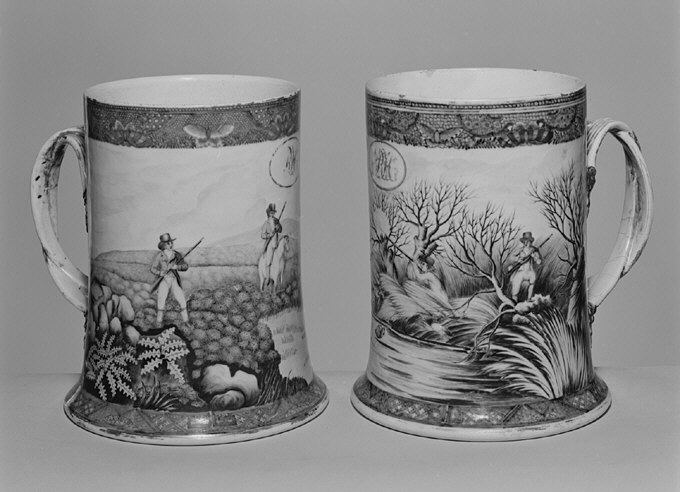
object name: mug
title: Pair of mugs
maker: samuel howitt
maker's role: artist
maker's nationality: british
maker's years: 1756-1823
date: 1810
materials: hard paste porcelain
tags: firearms,men,horses,landscapes